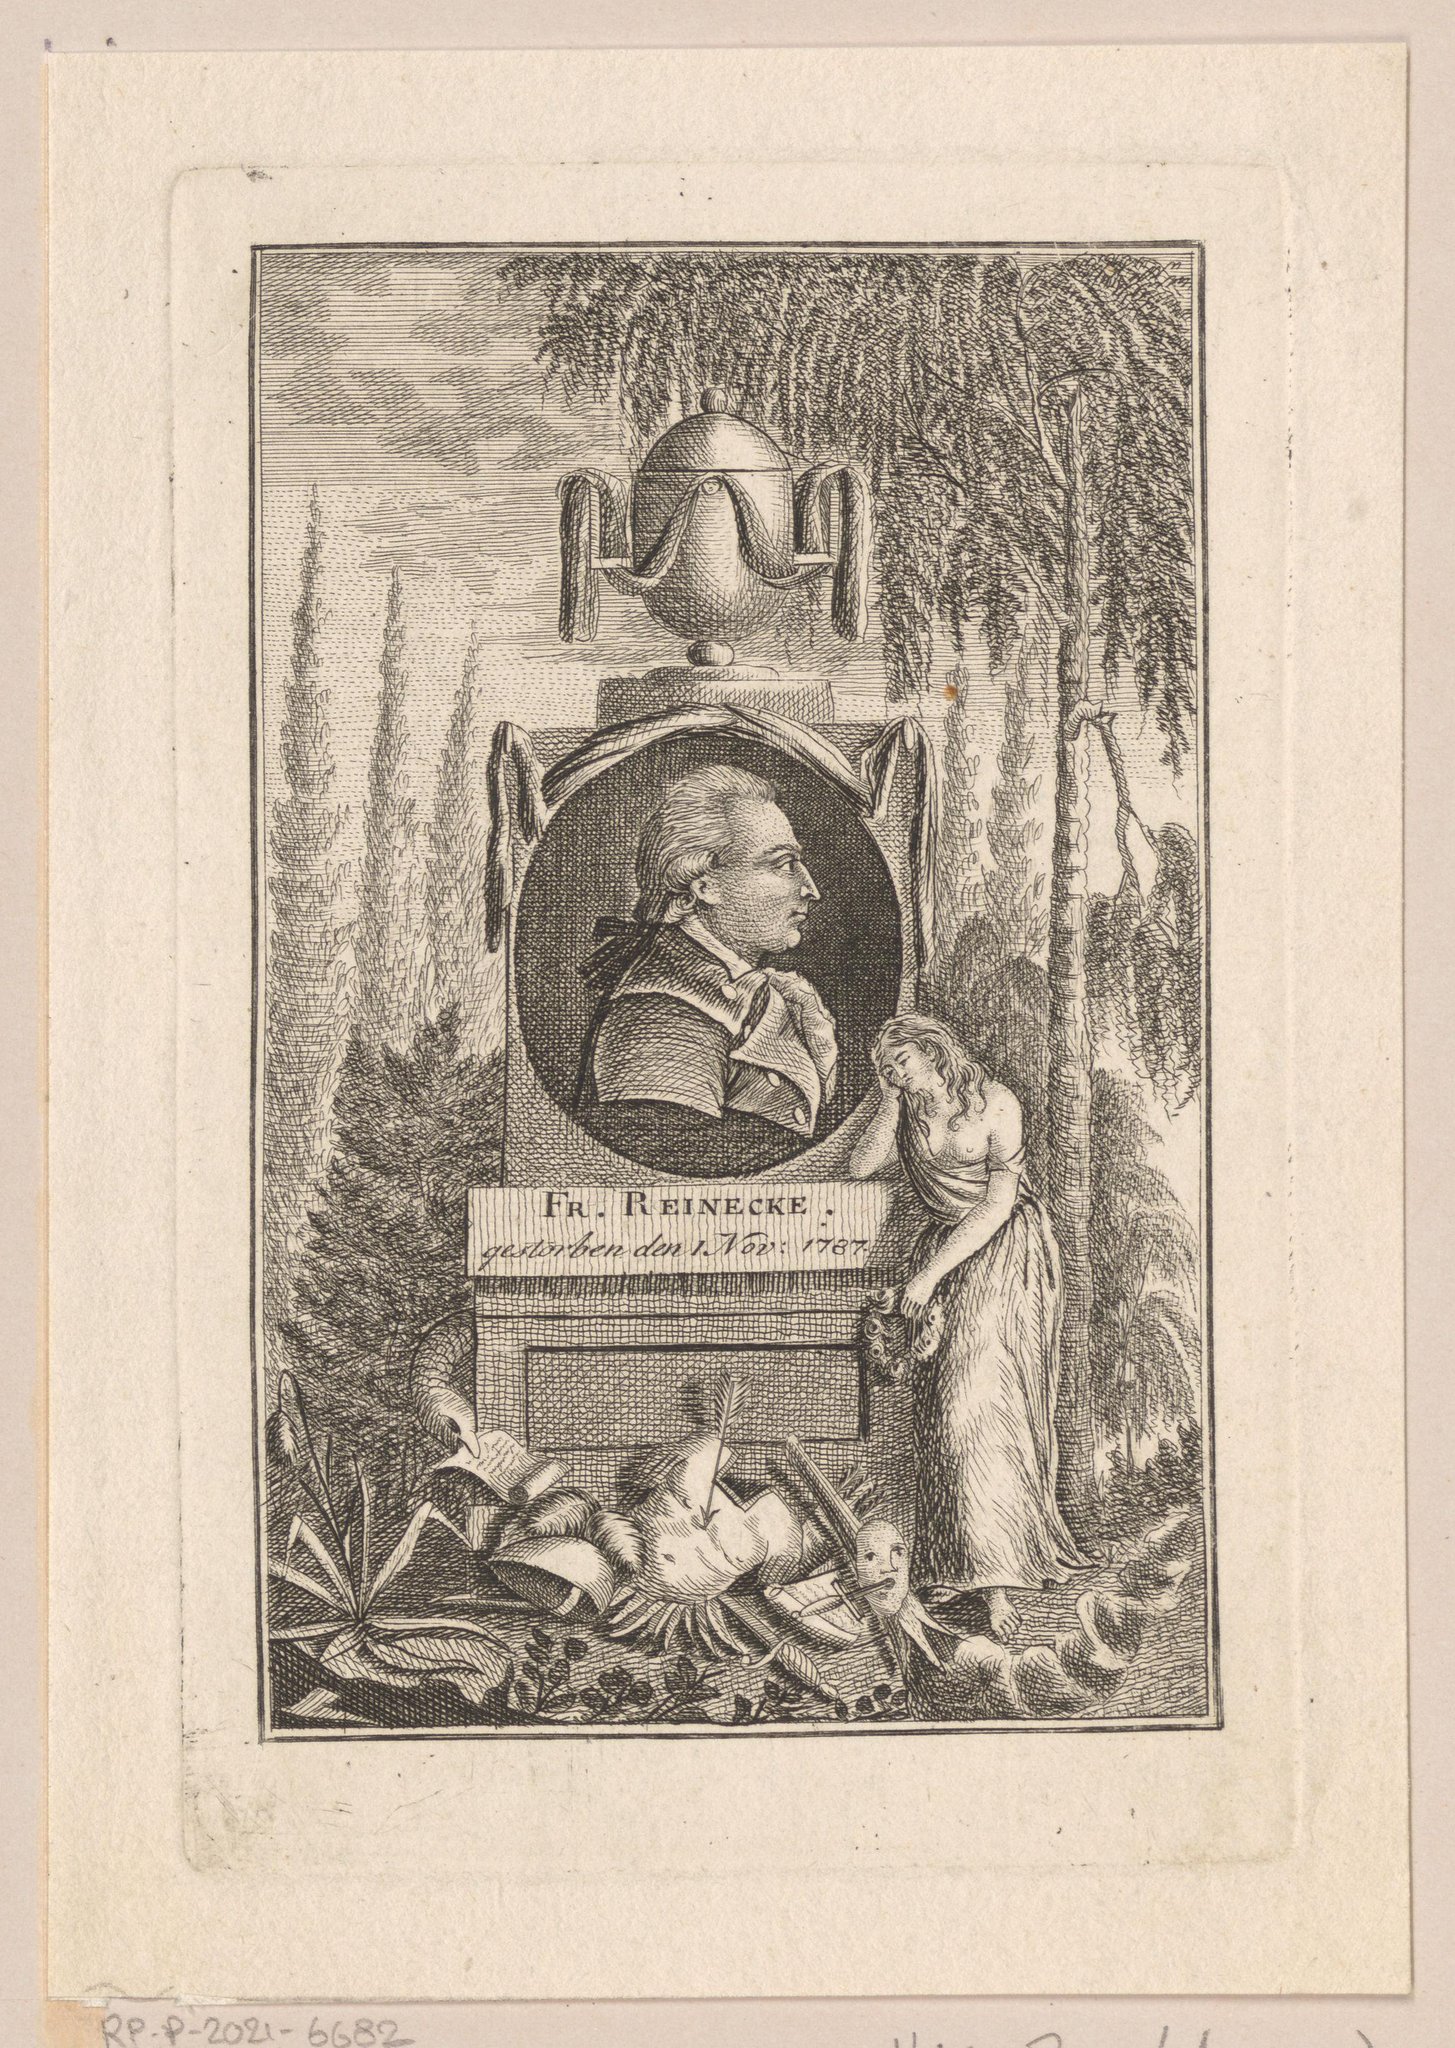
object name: print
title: Grafmonument met portret van Johann Friedrich Reinecke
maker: Anonymous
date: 1787-1797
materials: paper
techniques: engraving, etching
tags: mask, plants; vegetation, historical persons, grave, tomb